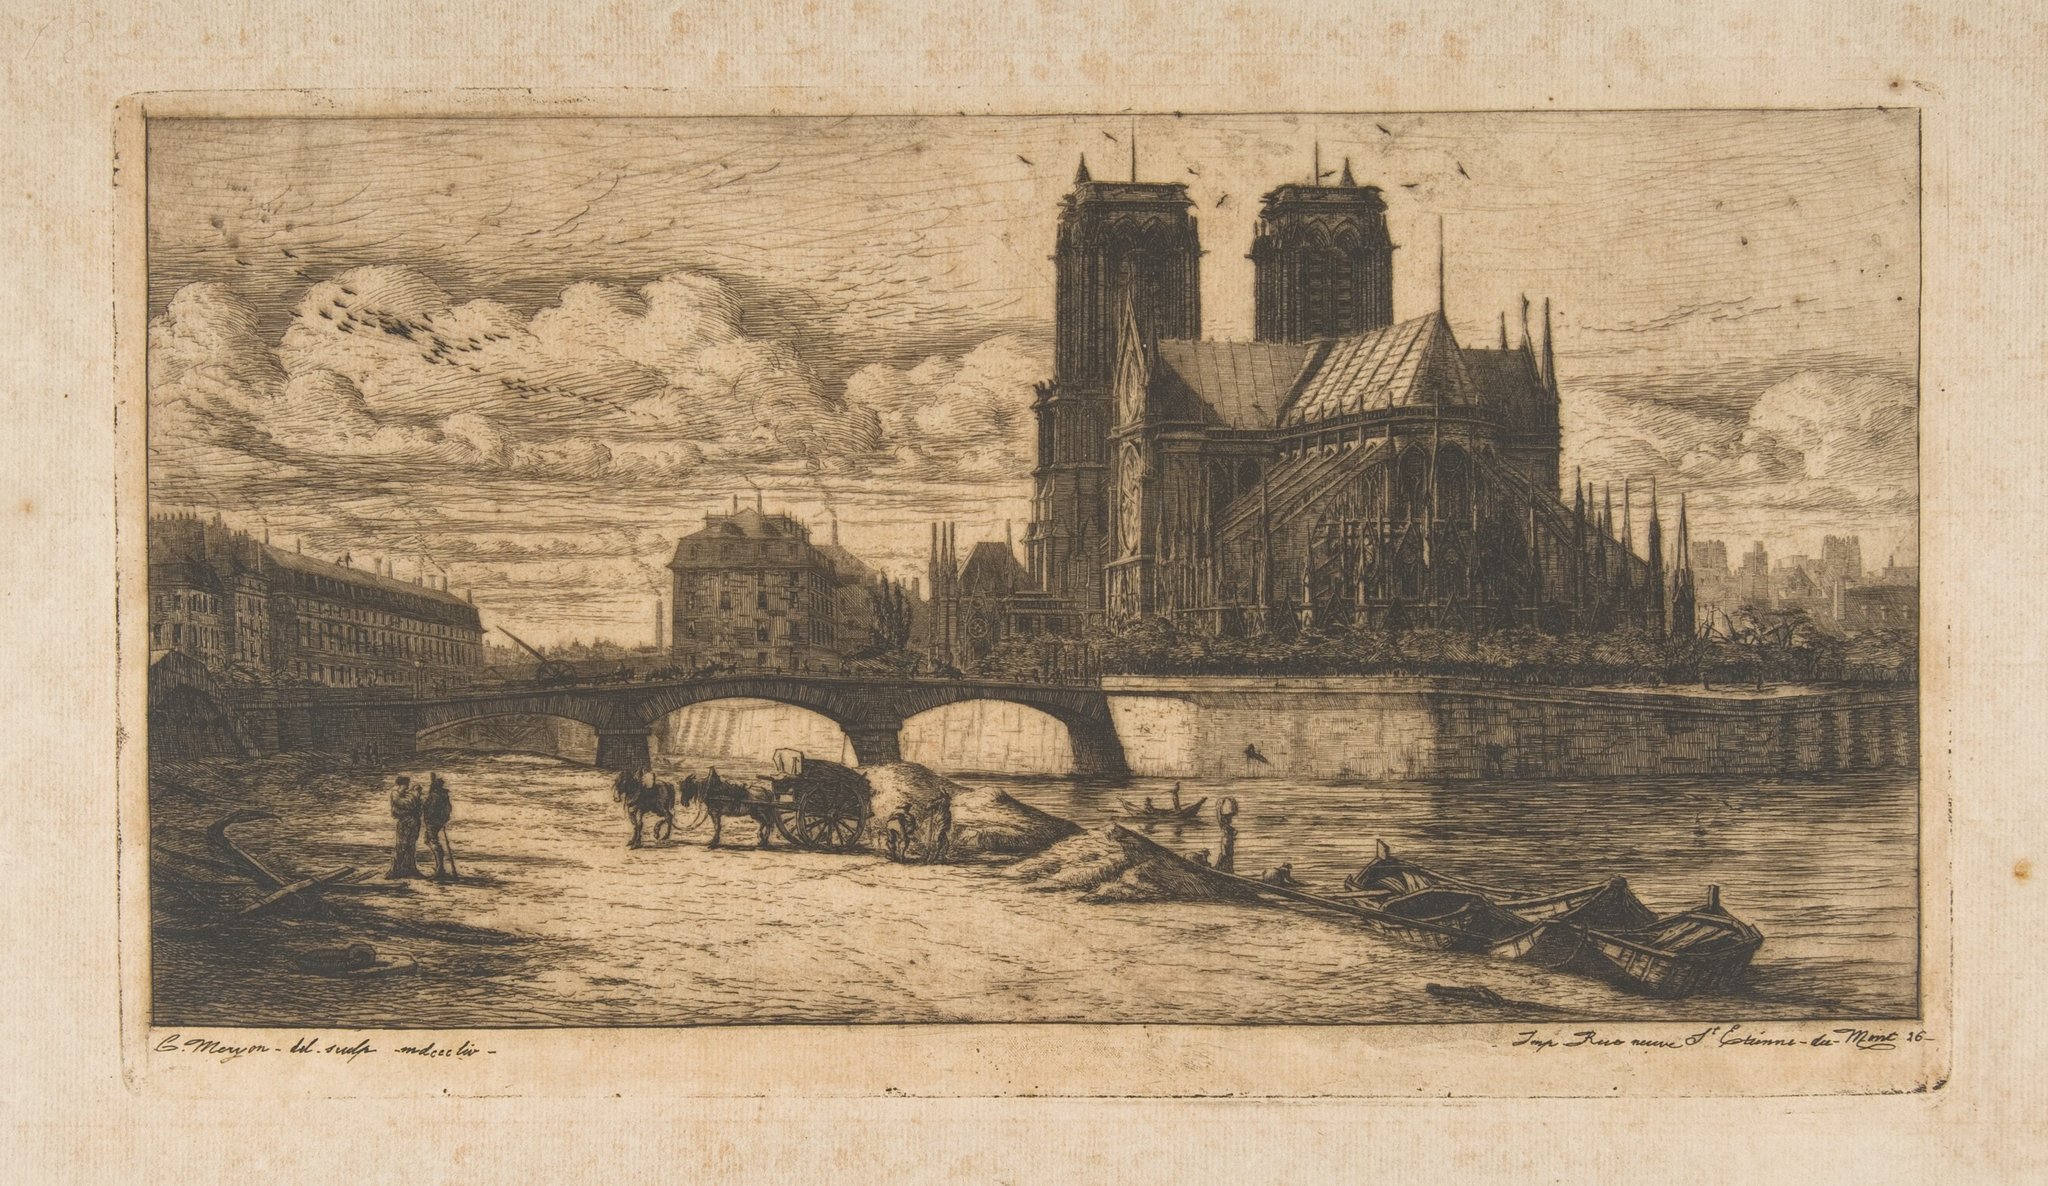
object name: print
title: The Apse of Notre-Dame, Paris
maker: charles meryon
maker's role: artist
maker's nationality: french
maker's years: 1821-1868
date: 1854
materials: paper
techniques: drypoint, engraving, etching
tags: bridges,cathedrals,boats,paris